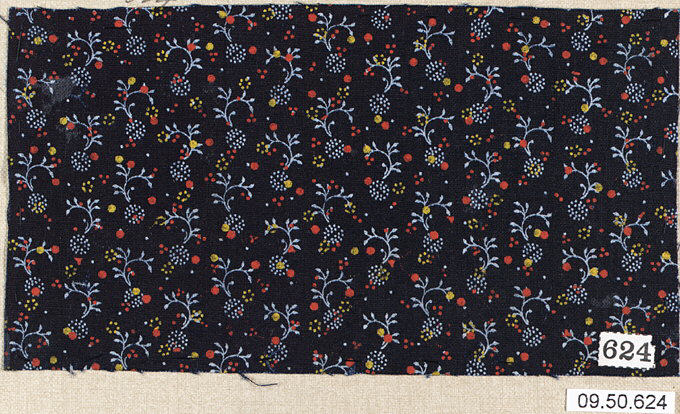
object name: piece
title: Pieces (4)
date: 1801-1900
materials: cotton